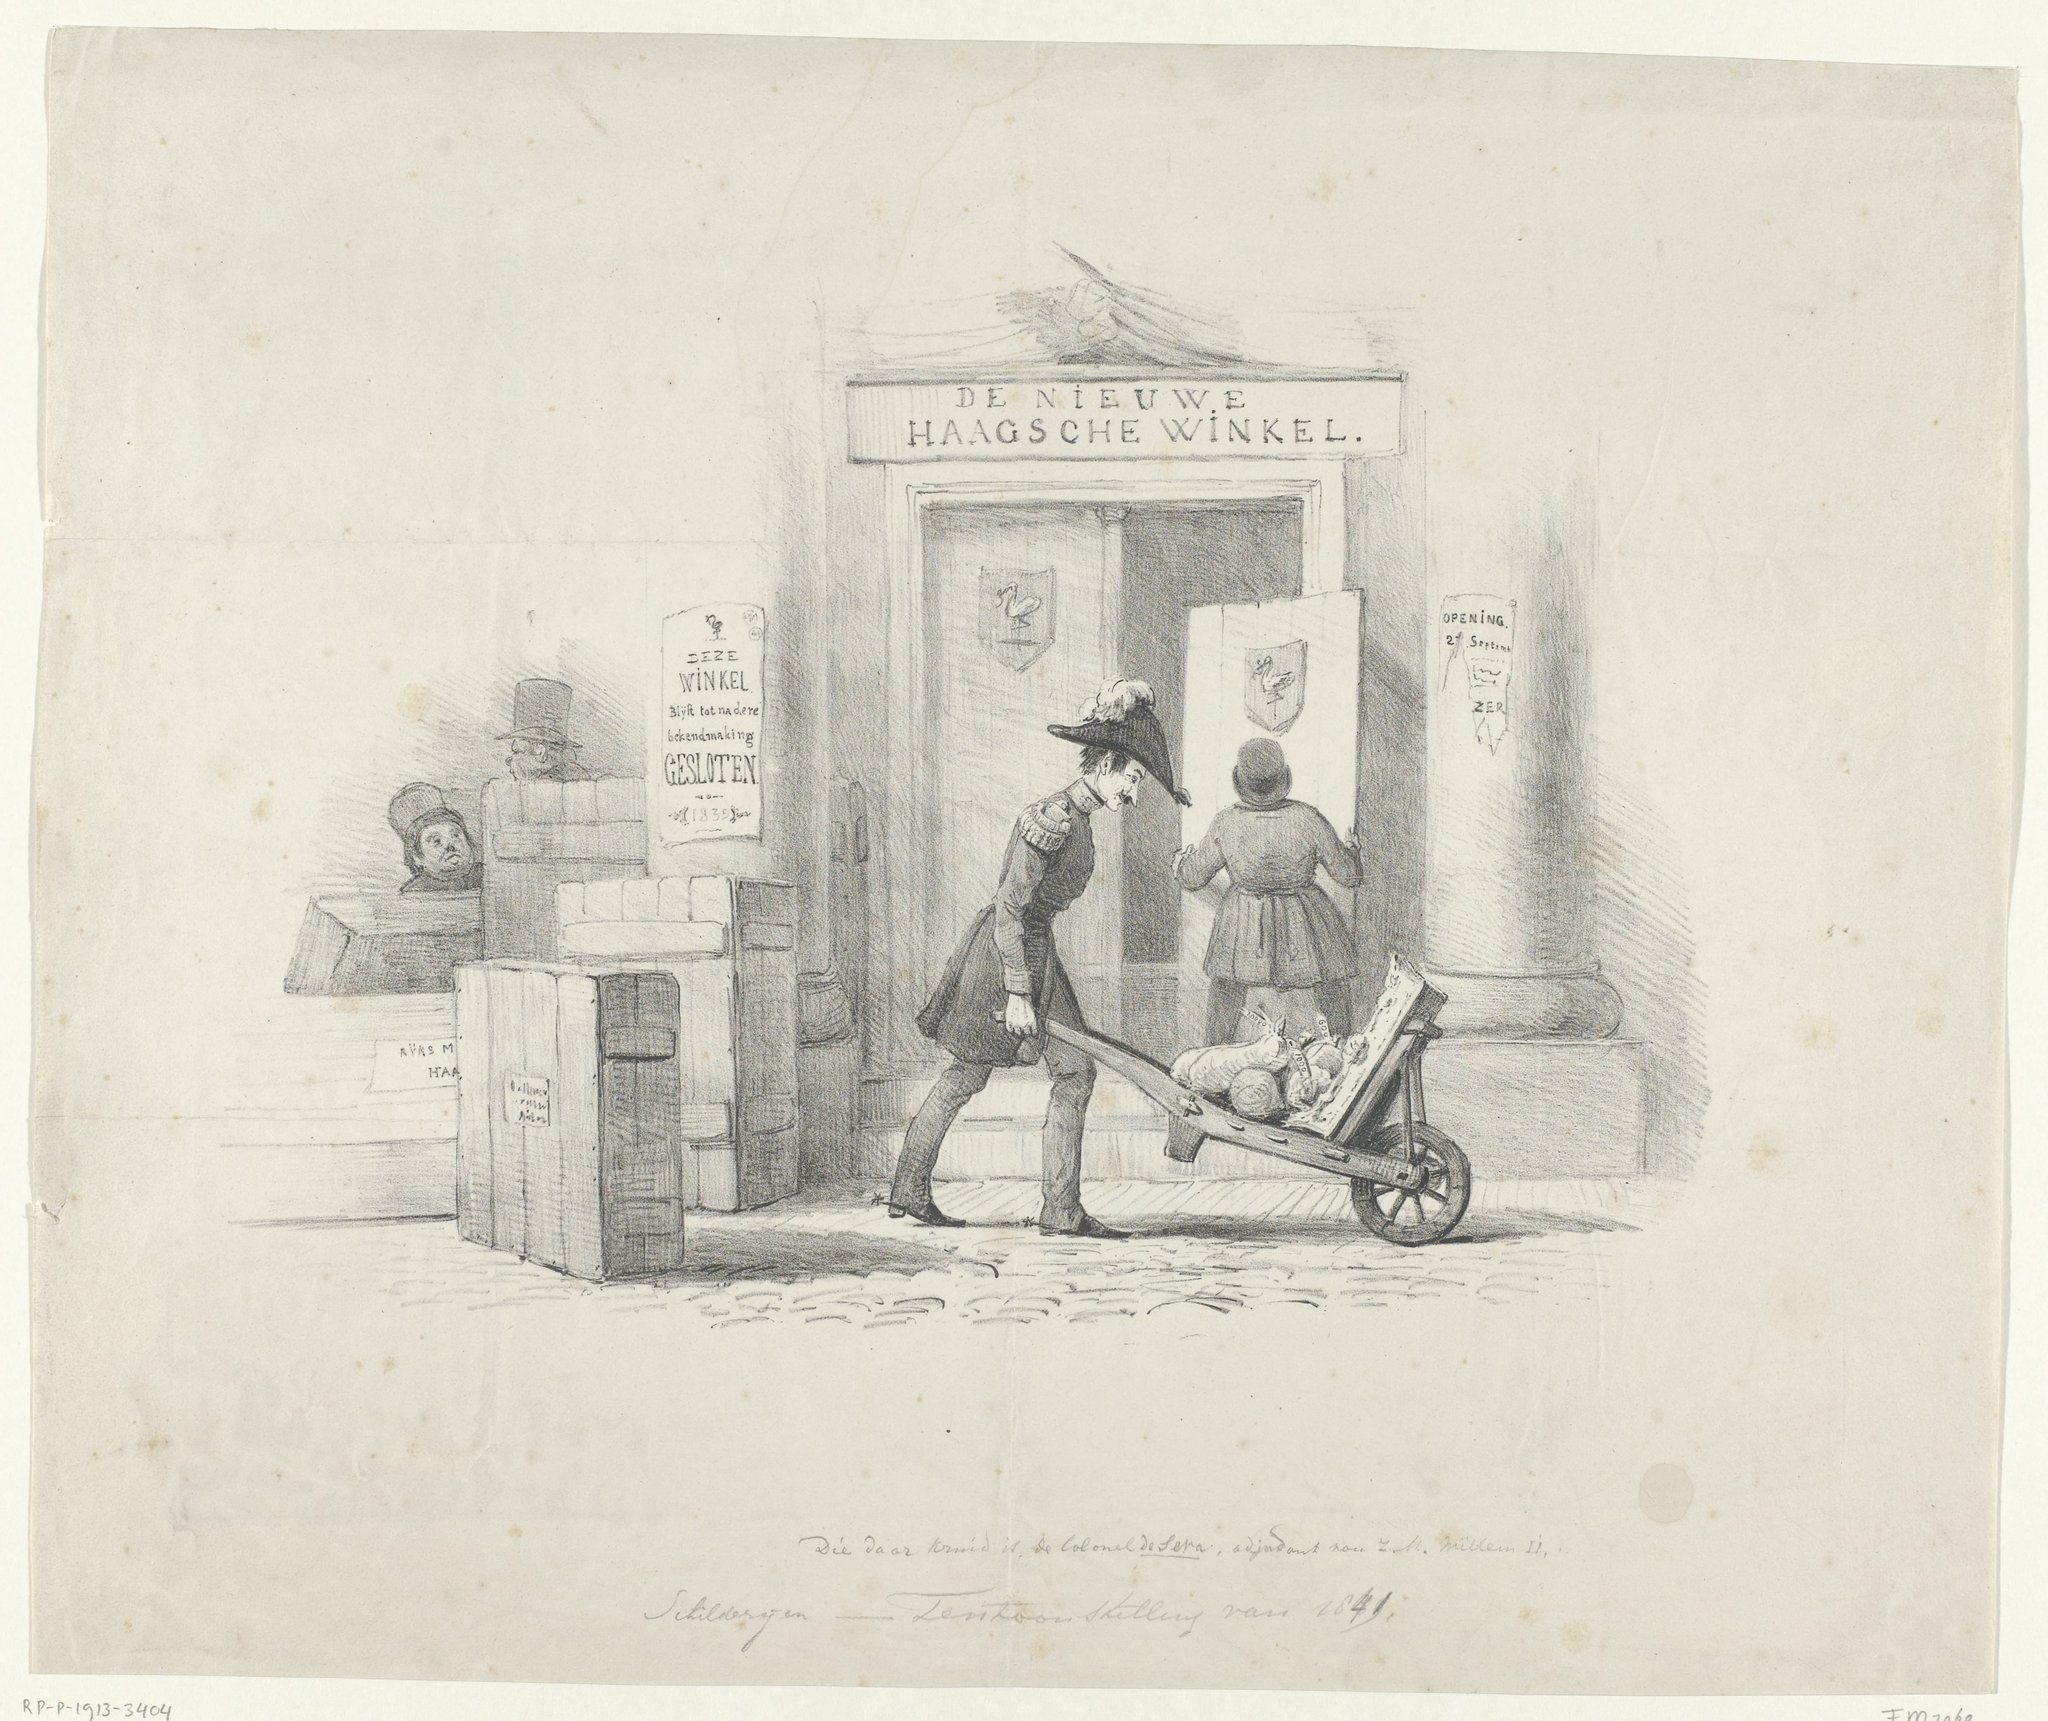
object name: print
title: De Nieuwe Haagsche Winkel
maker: Anonymous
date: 1839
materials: paper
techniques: lithograph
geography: netherlands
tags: rijksmuseum amsterdam, art collection, art gallery, picture, painting, collection, exhibition, show, the hague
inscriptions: collector's mark: Lugt 2228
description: Spotprent op de tentoonstelling van schilderijen van levende meesters in Den Haag in 1839. De bekroonde werken bleken meerdendeels van Brabantse kunstenaars en volgens geruchten reeds vóór de tentoonstelling eigendom van Baron de Ceva, adjudant van Prins Frederik en lid van de tentoonstellingscommissie. Terwijl de winkel dicht getimmerd wordt vertrekt de baron De Ceva met een kruiwagen beladen met geldzakken en een schilderij. Links enkele kisten met schilderijen klaar voor transport, één met etiket 'Rijks m(useum) Haa(rlem)' en de ander met 'Musee russe péter(sbourg)'.